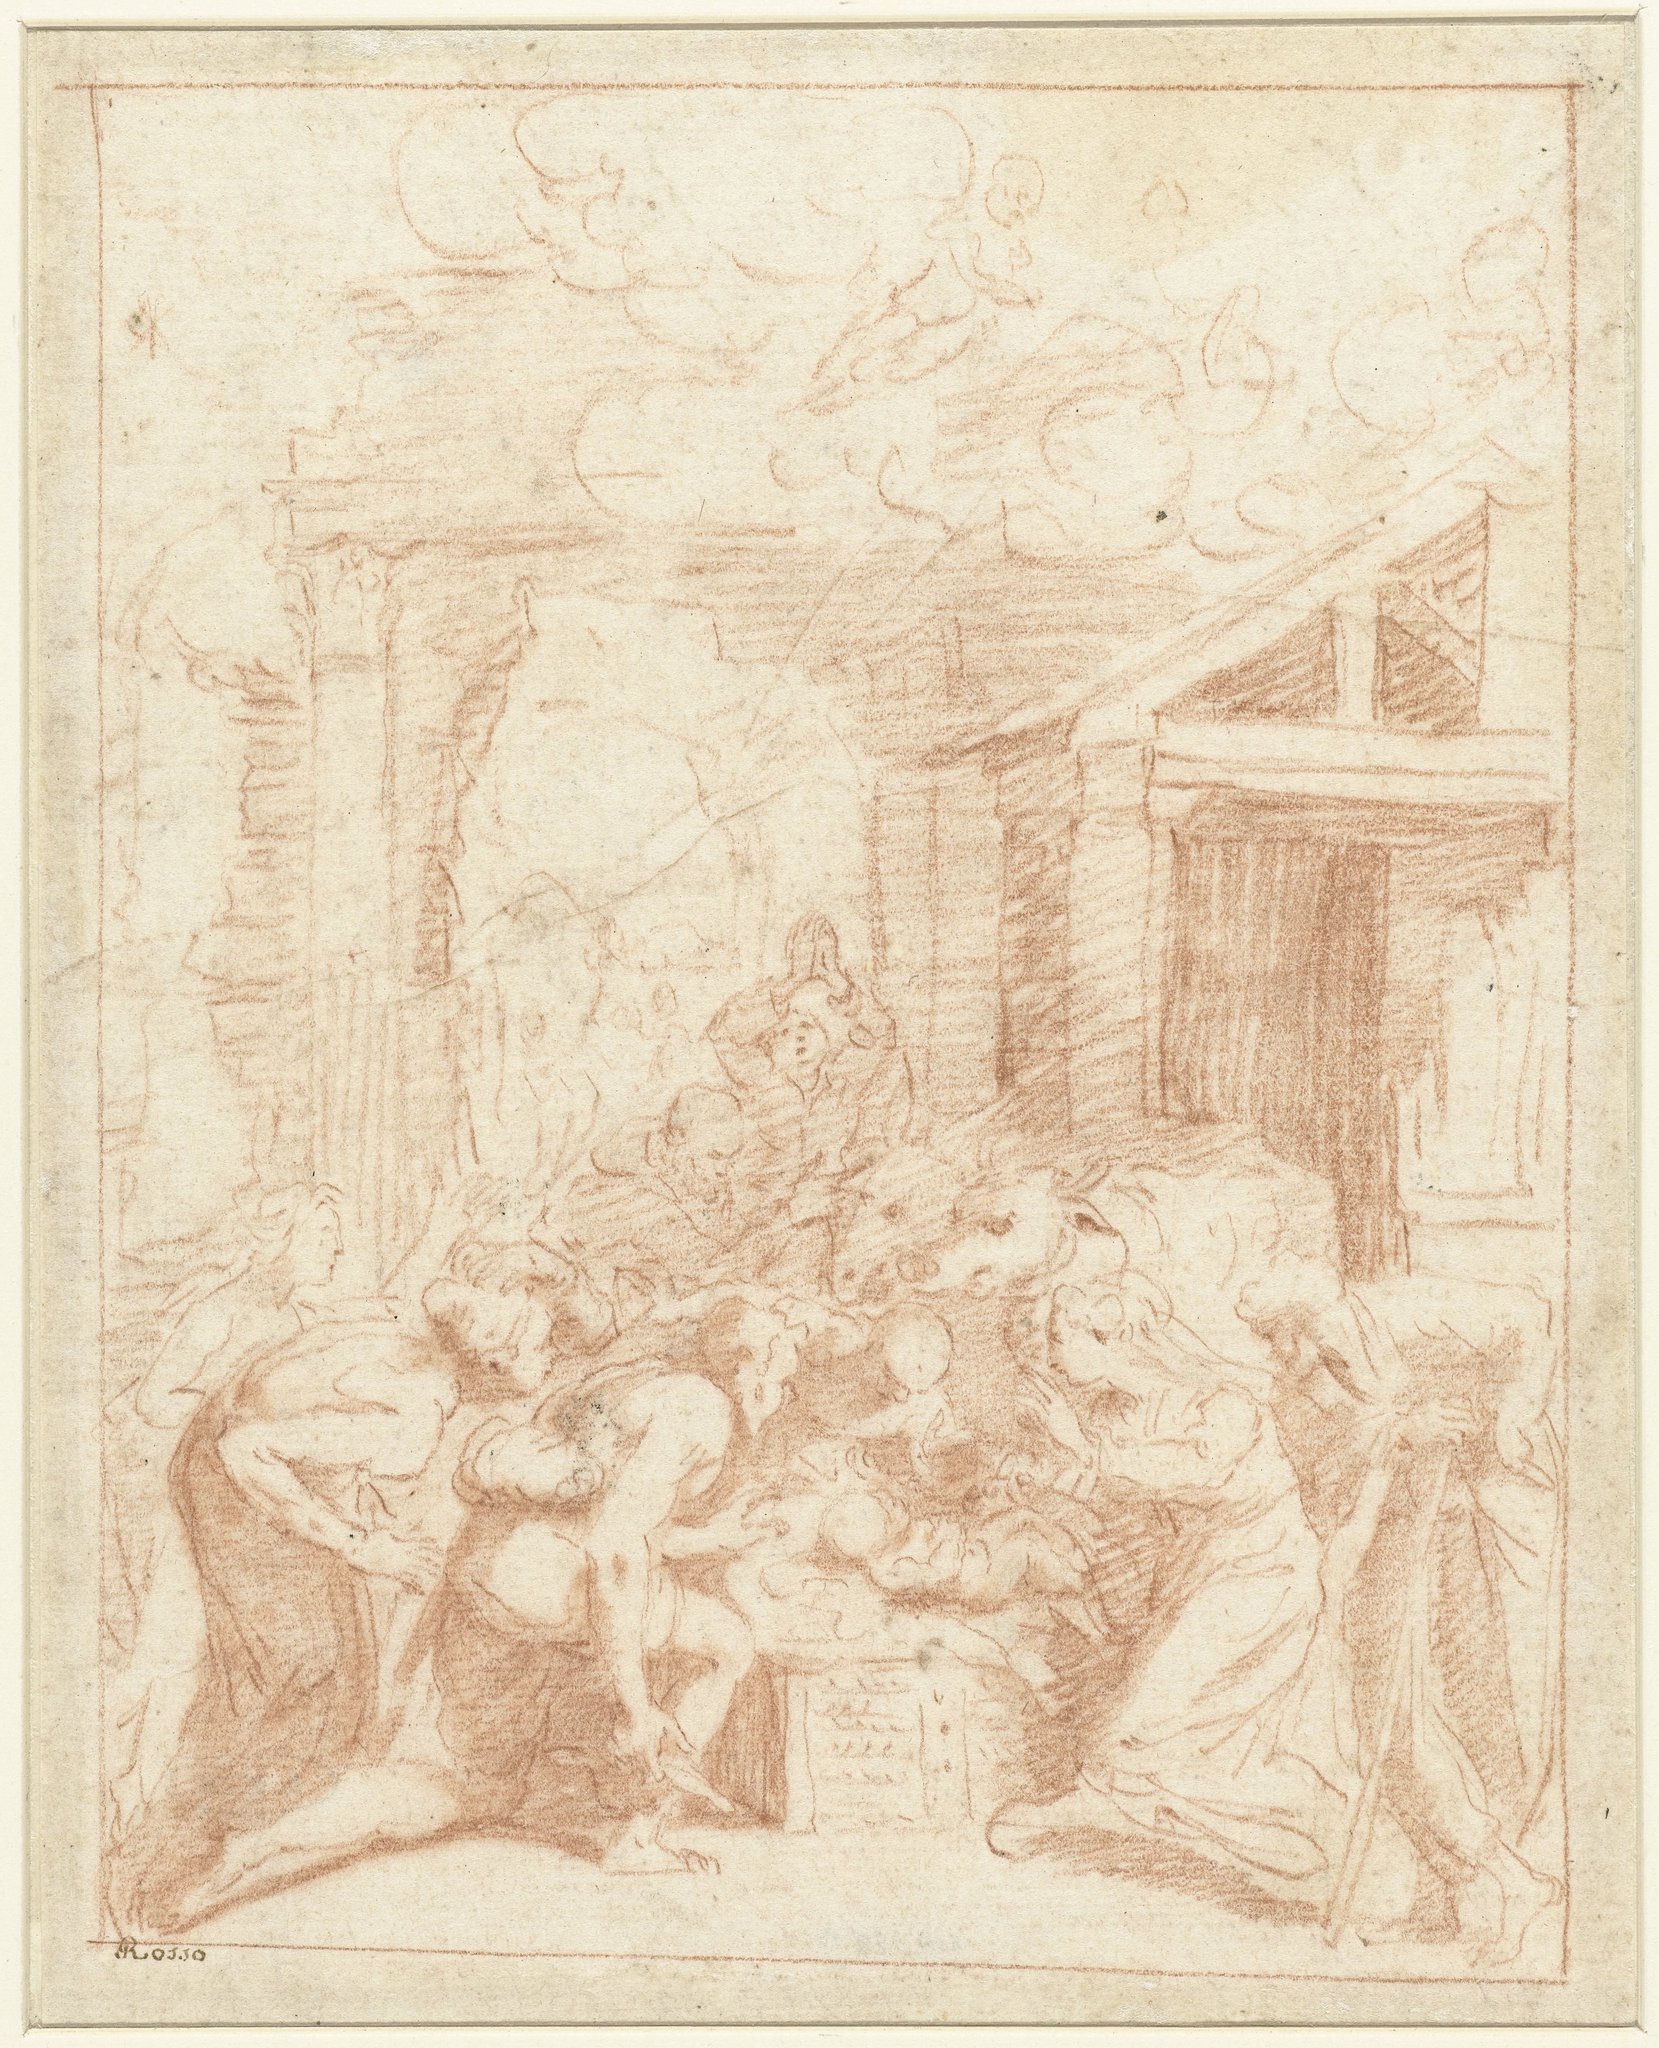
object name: drawing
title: Aanbidding der herders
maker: Anonymous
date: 1530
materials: chalk, paper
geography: parma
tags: adoration of the christ-child by the shepherds; mary and joseph present